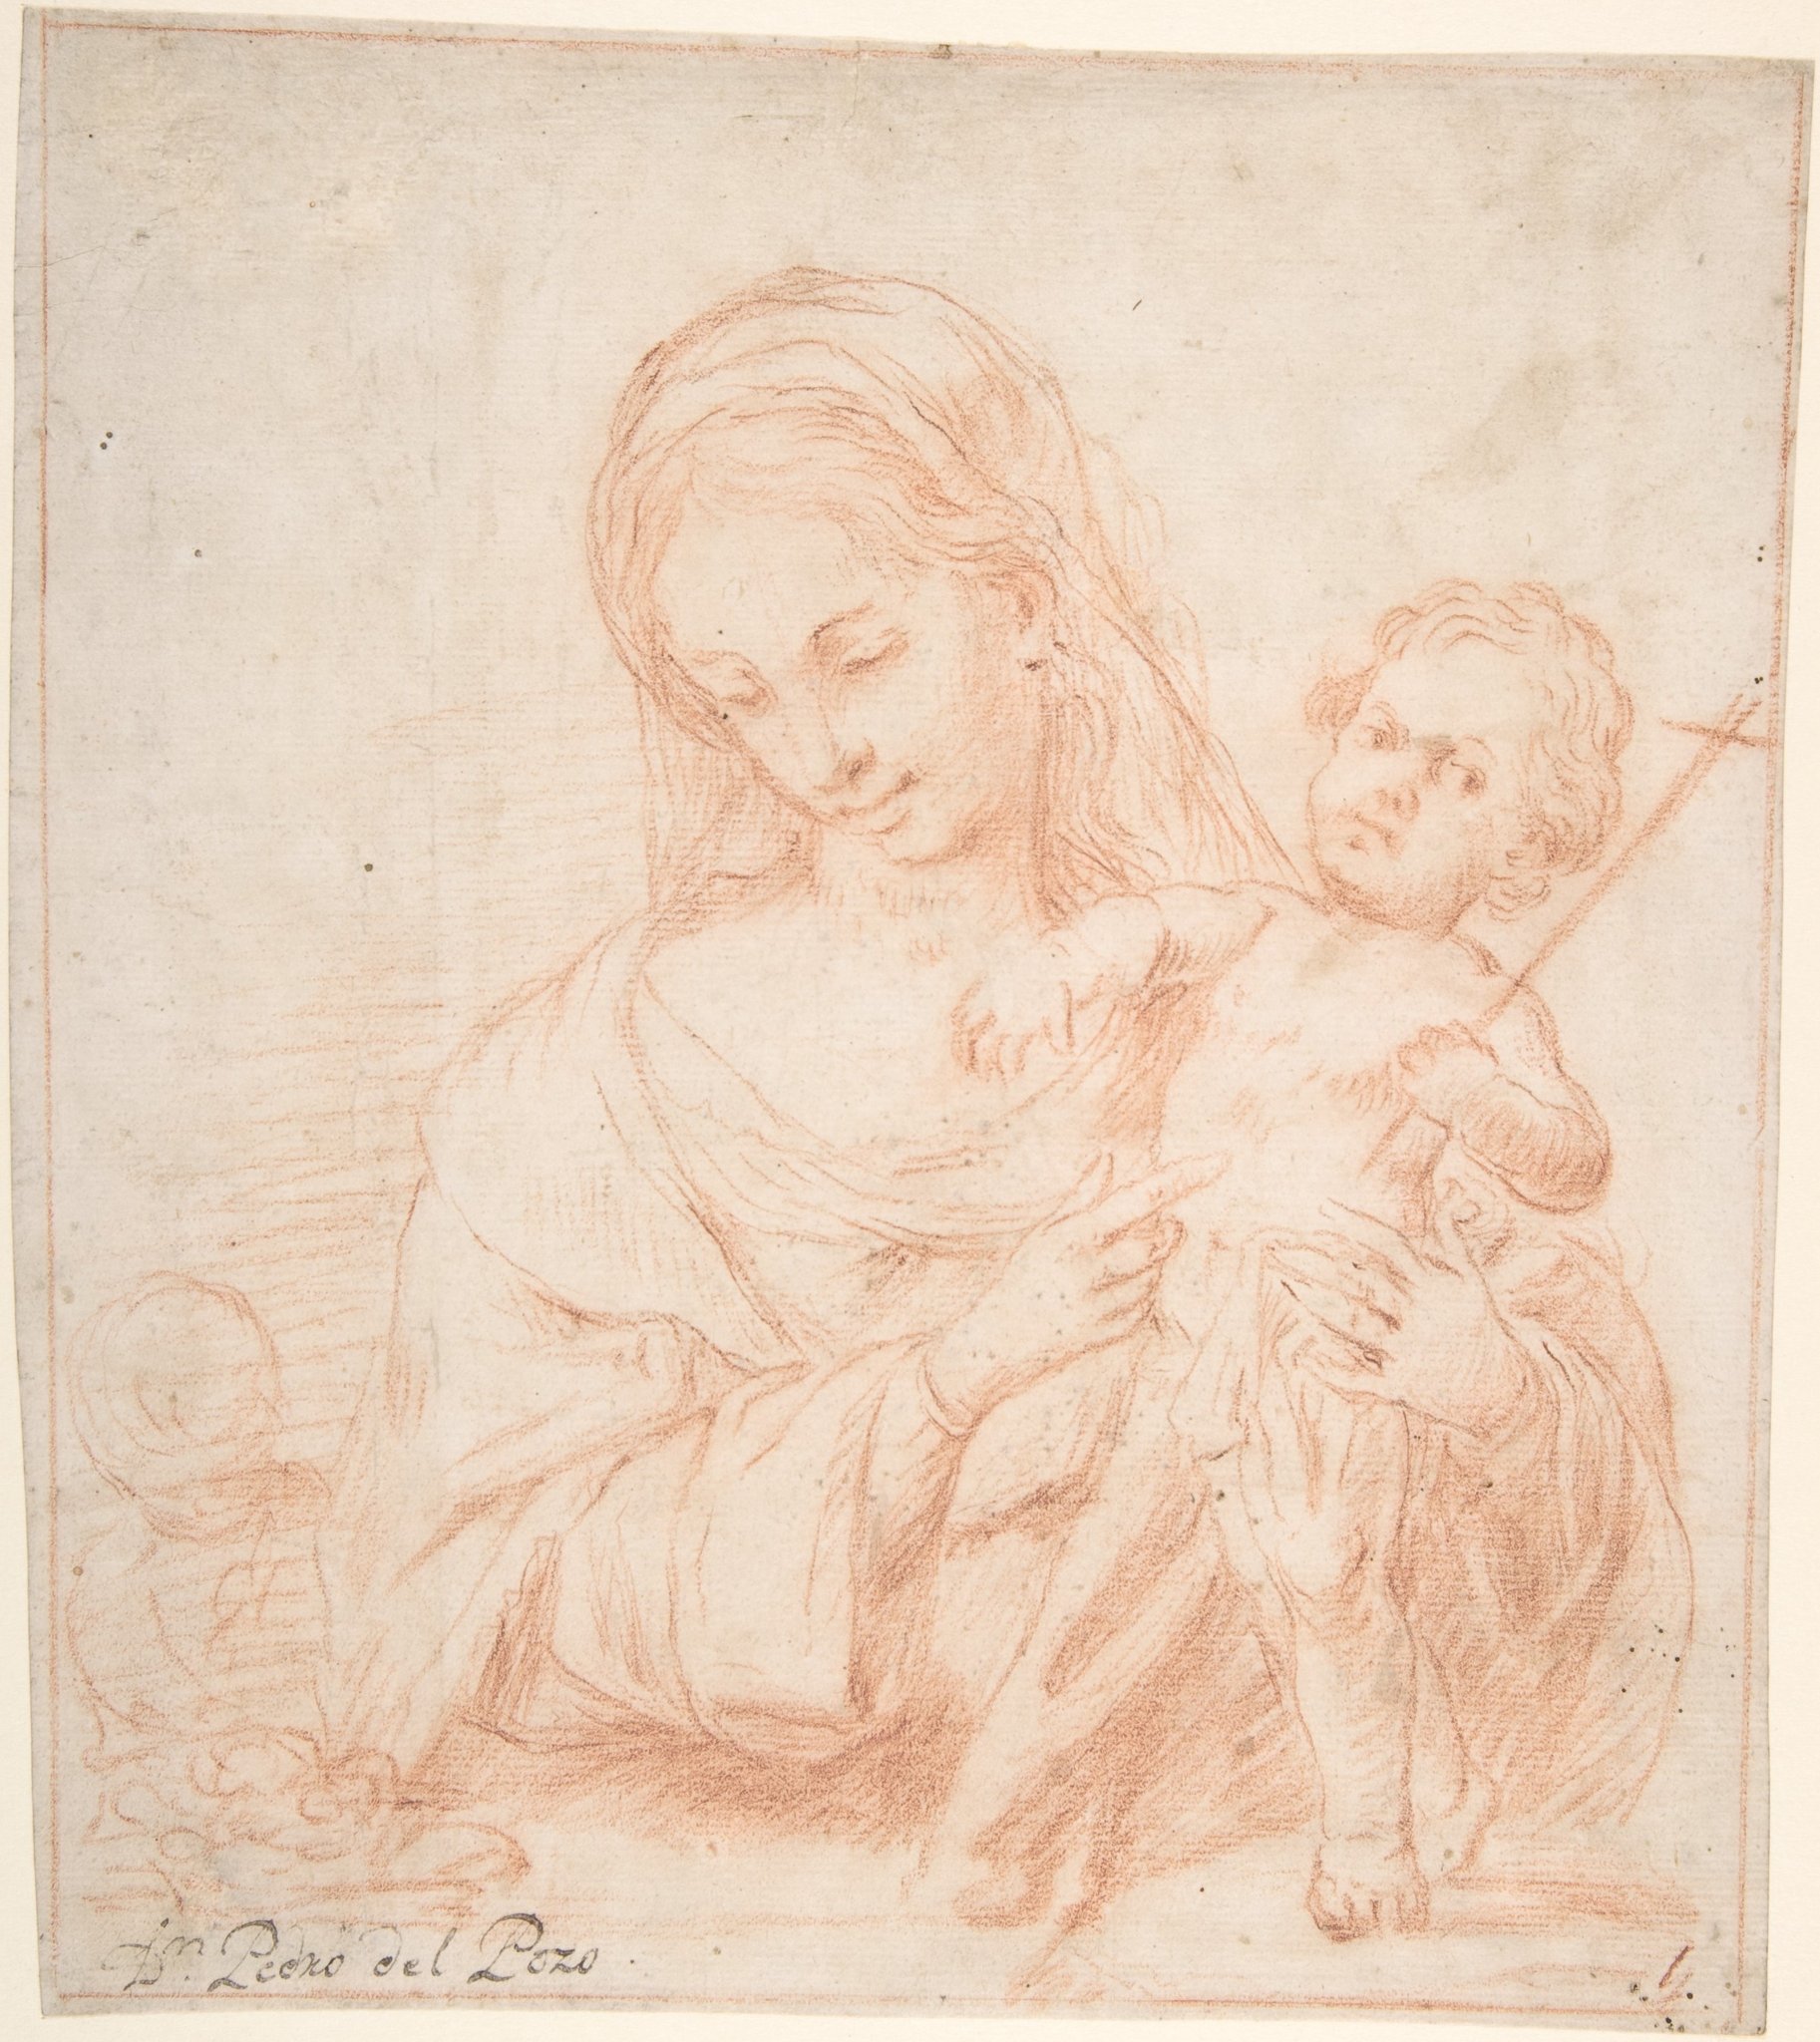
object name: drawing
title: Half-length Virgin and Standing Child with Indications of a Young Saint John the Baptist at Left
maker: pedro del pozo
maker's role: artist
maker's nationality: spanish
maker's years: 18-1785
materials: chalk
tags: madonna and child,saint john the baptist